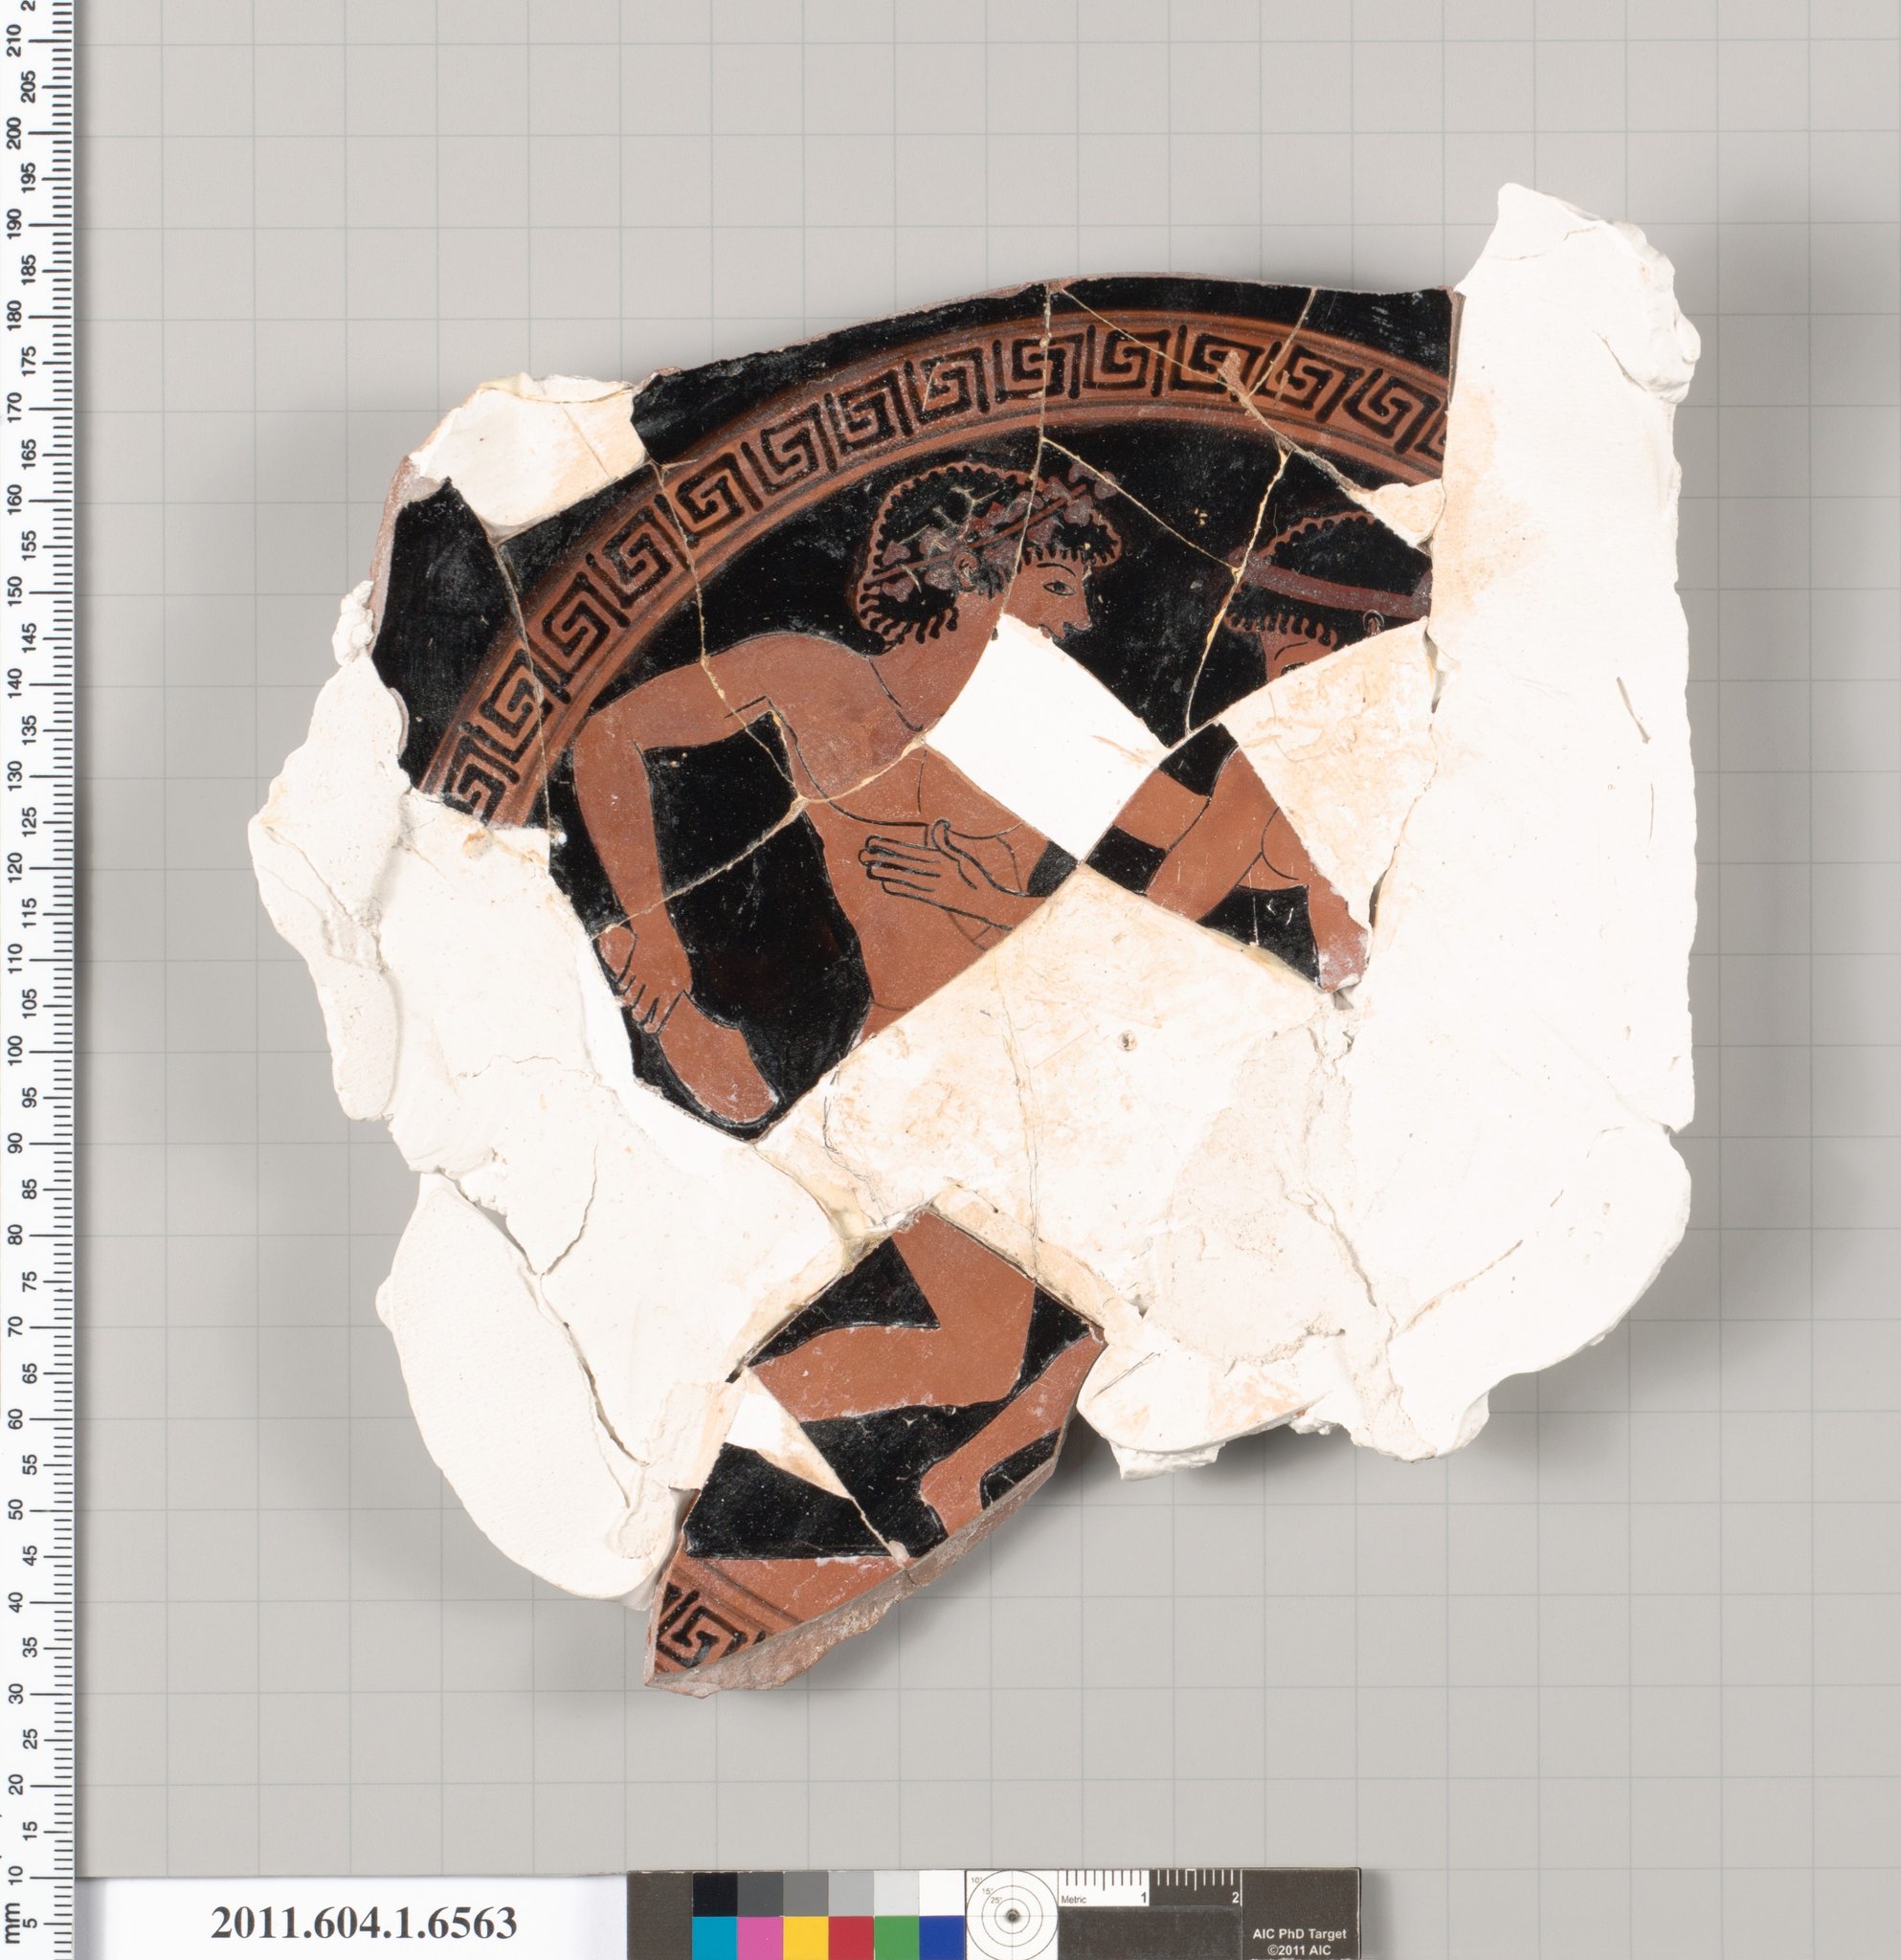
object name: kylix fragment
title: Terracotta fragment of a kylix (drinking cup)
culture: greek, attic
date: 490-480 BCE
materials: terracotta